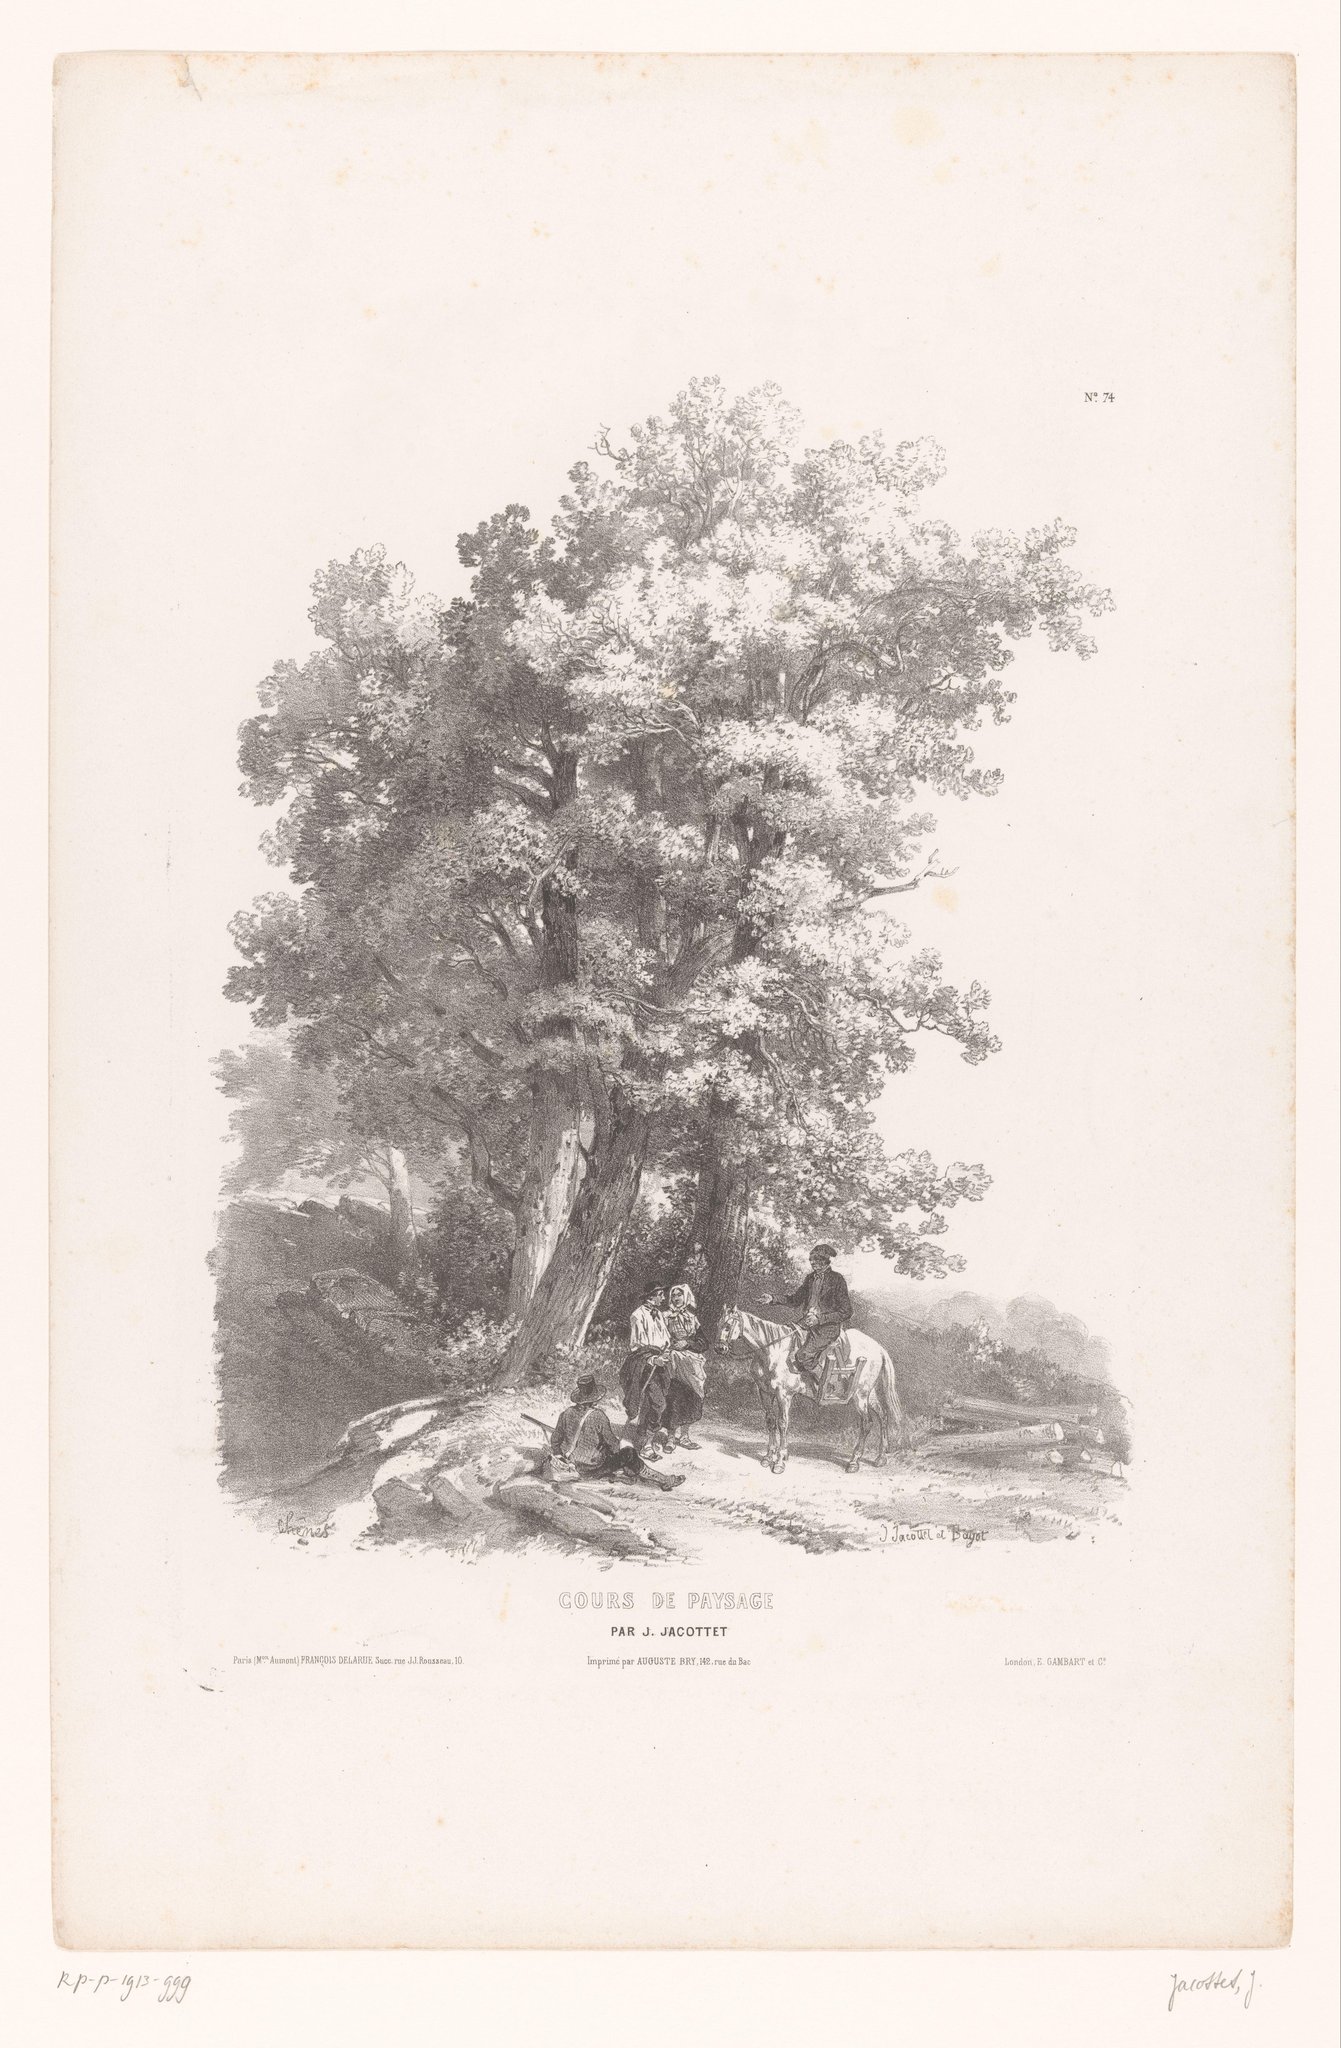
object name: print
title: Cours de Paysage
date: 1850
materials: paper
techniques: lithograph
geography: paris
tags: riding a horse, ass, or mule; rider, horseman, trees, hunters resting during the hunt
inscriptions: collector's mark: Lugt 2228a